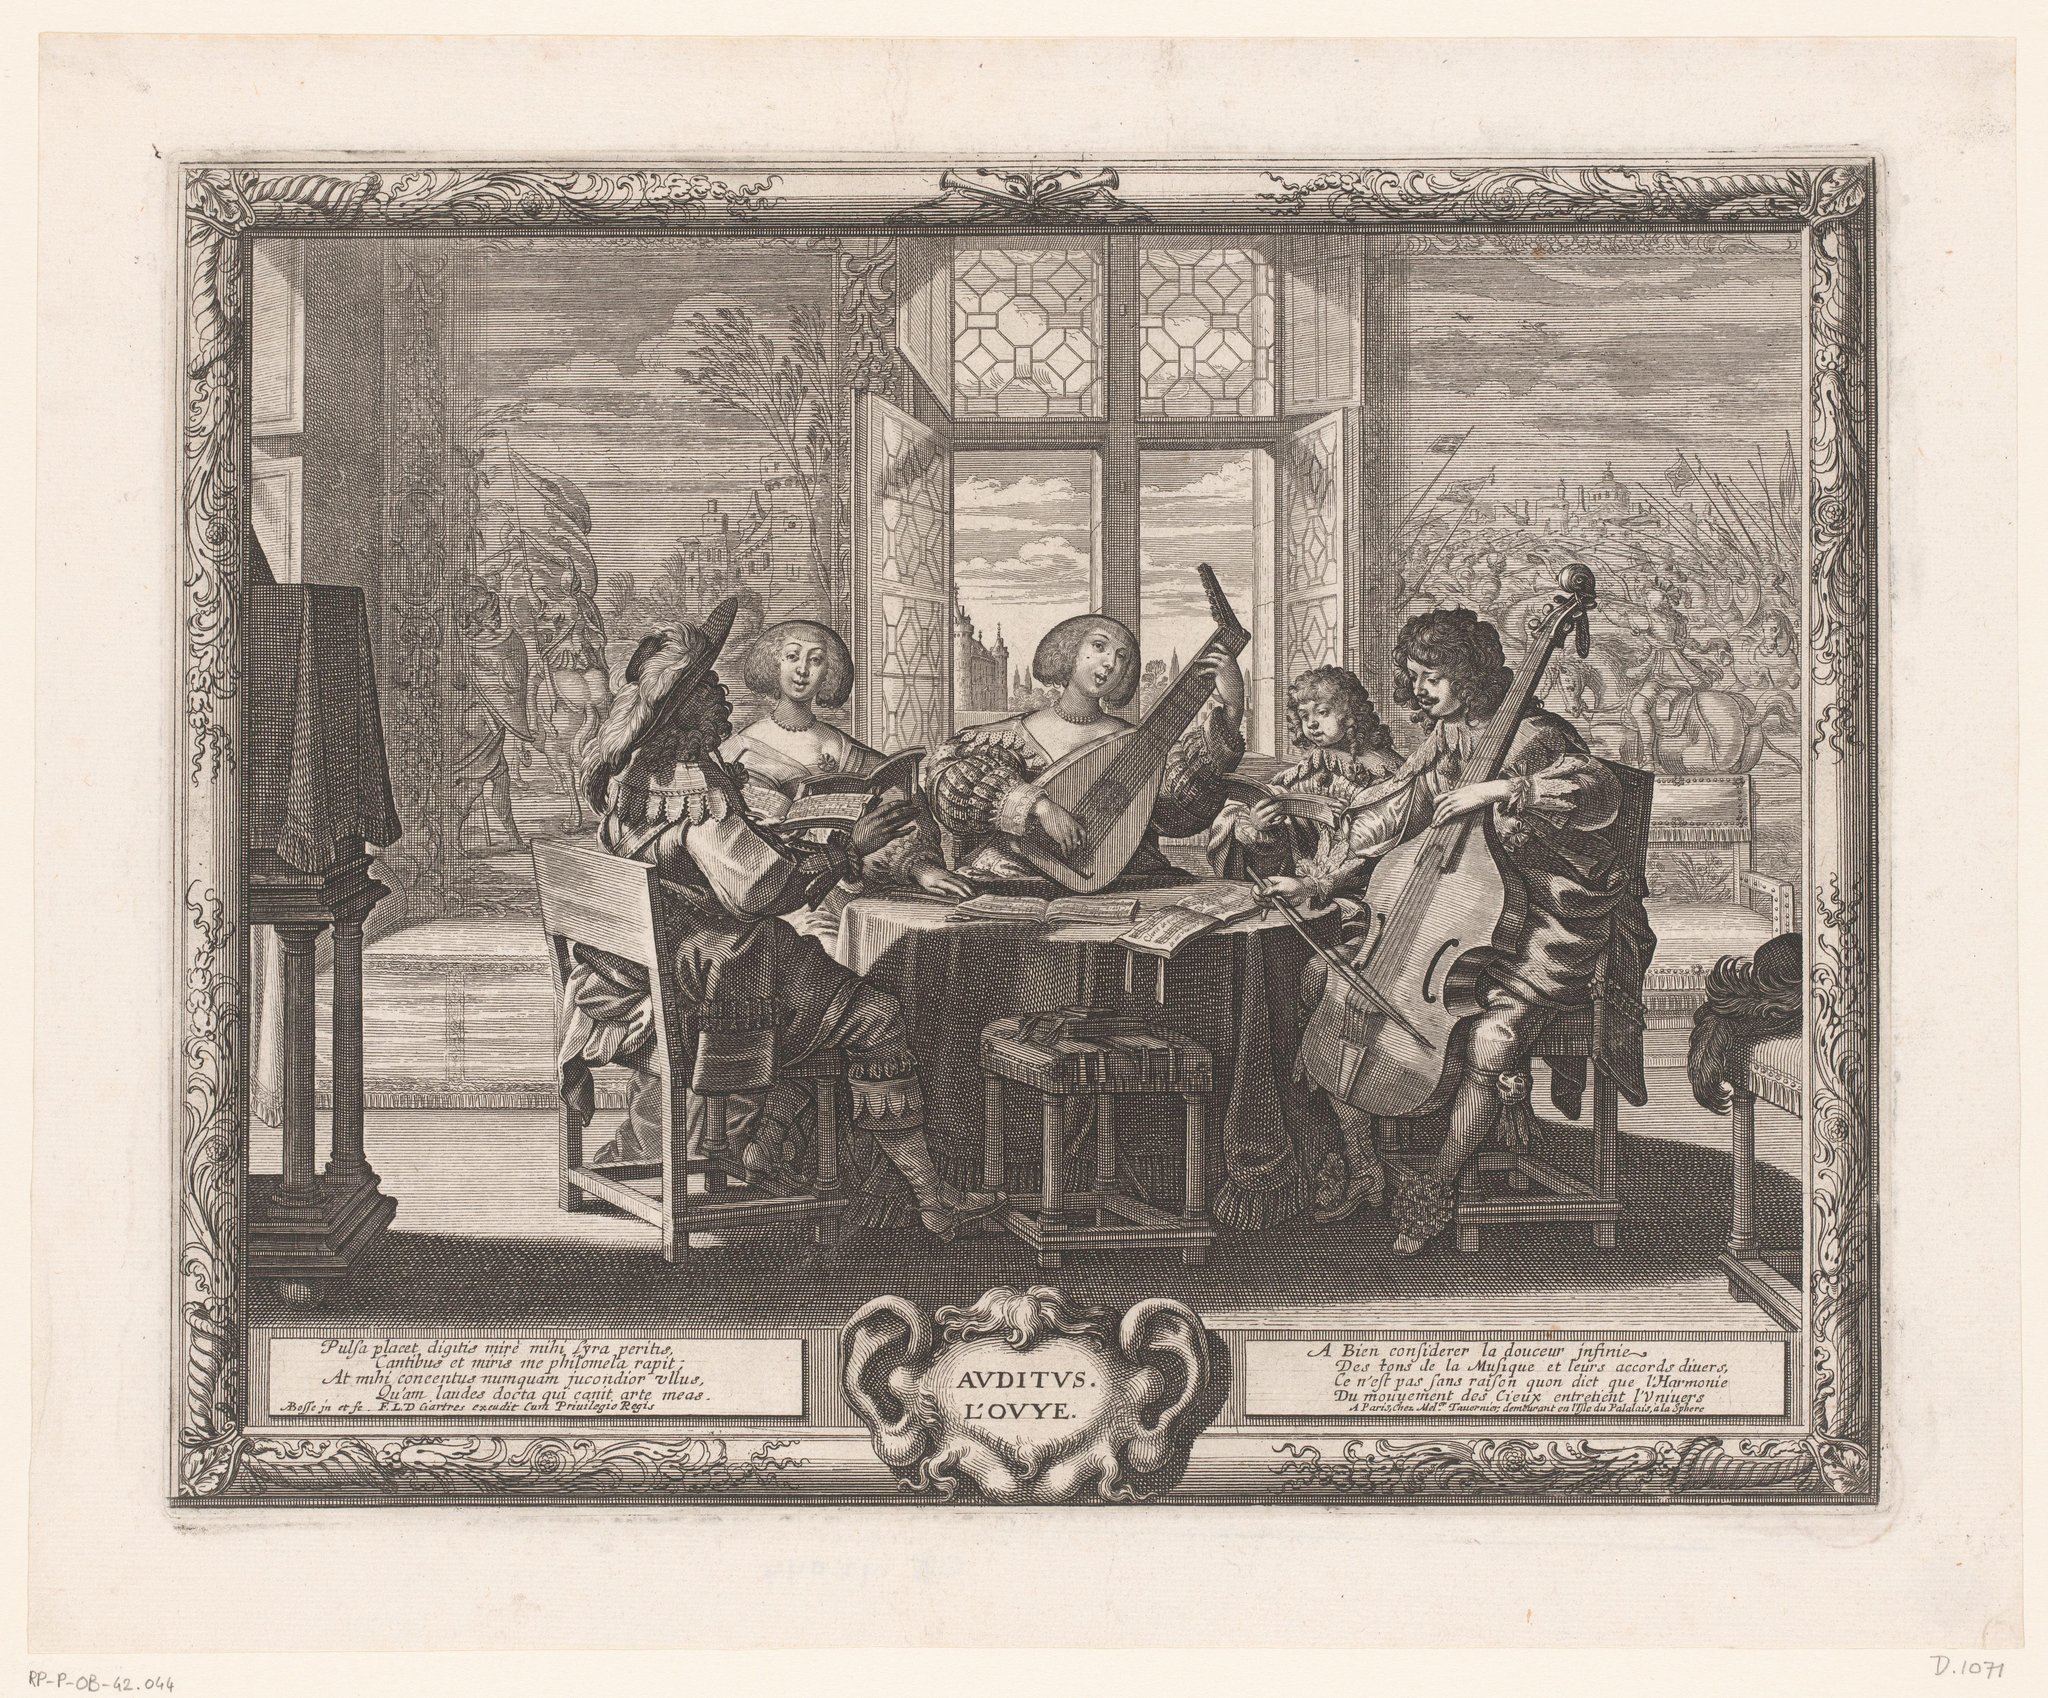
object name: print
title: Hearing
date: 1635-1636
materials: paper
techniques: engraving, etching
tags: hearing, listening (one of the five senses), making music; musician with instrument, viola, violoncello; double bass, lute, and special forms of lute, e.g.: theorbo, tapestry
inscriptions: collector's mark: Lugt 240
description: House concerts brought people together in small groups. They provided social interaction, joy, and fellowship. In order to participate in these middle- and upper-class forms of entertainment young people had to be able to sing, read music and play one or more instrument. Music-making was a language of interaction and a sign of social distinction.